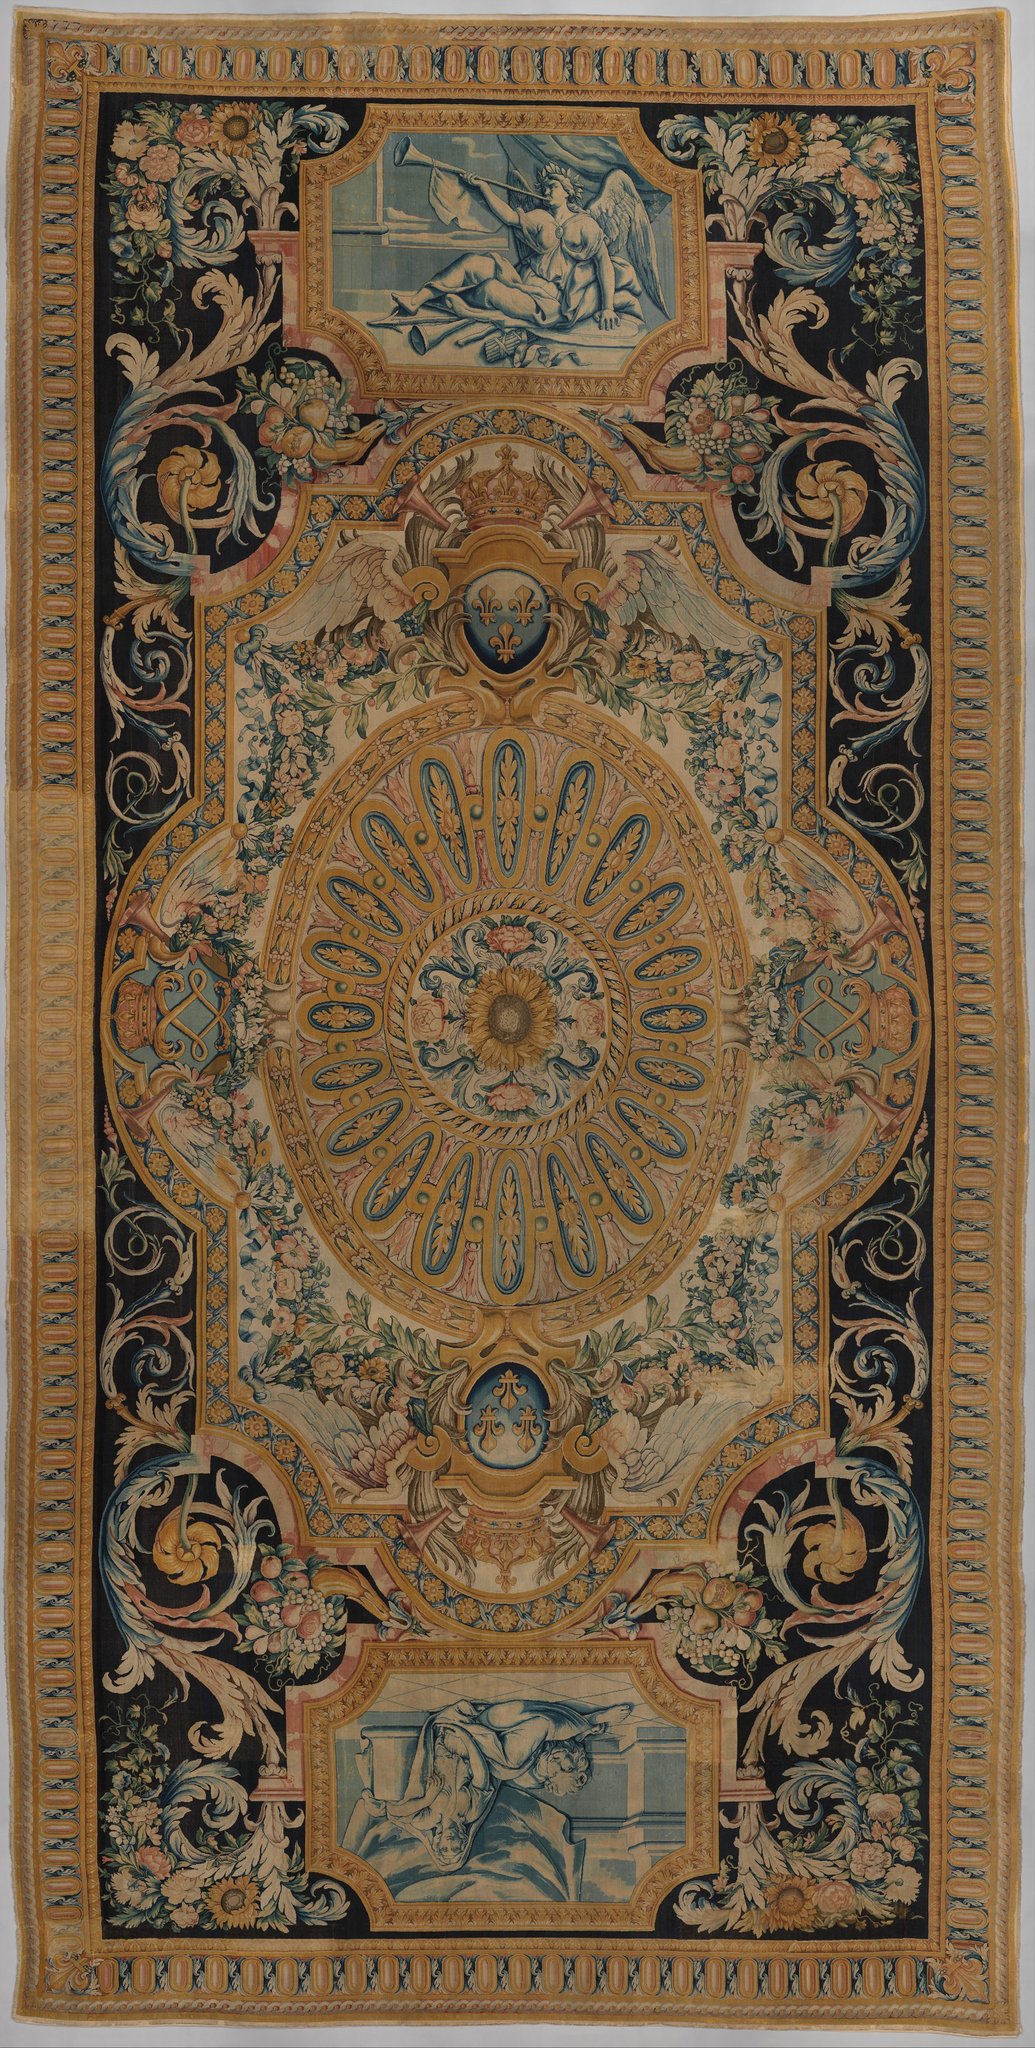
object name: carpet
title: Carpet with Fame and Fortitude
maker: savonnerie manufactory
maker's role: manufactory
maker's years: 1626-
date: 1668-1685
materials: wool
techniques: cutting, weave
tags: flowers,coat of arms